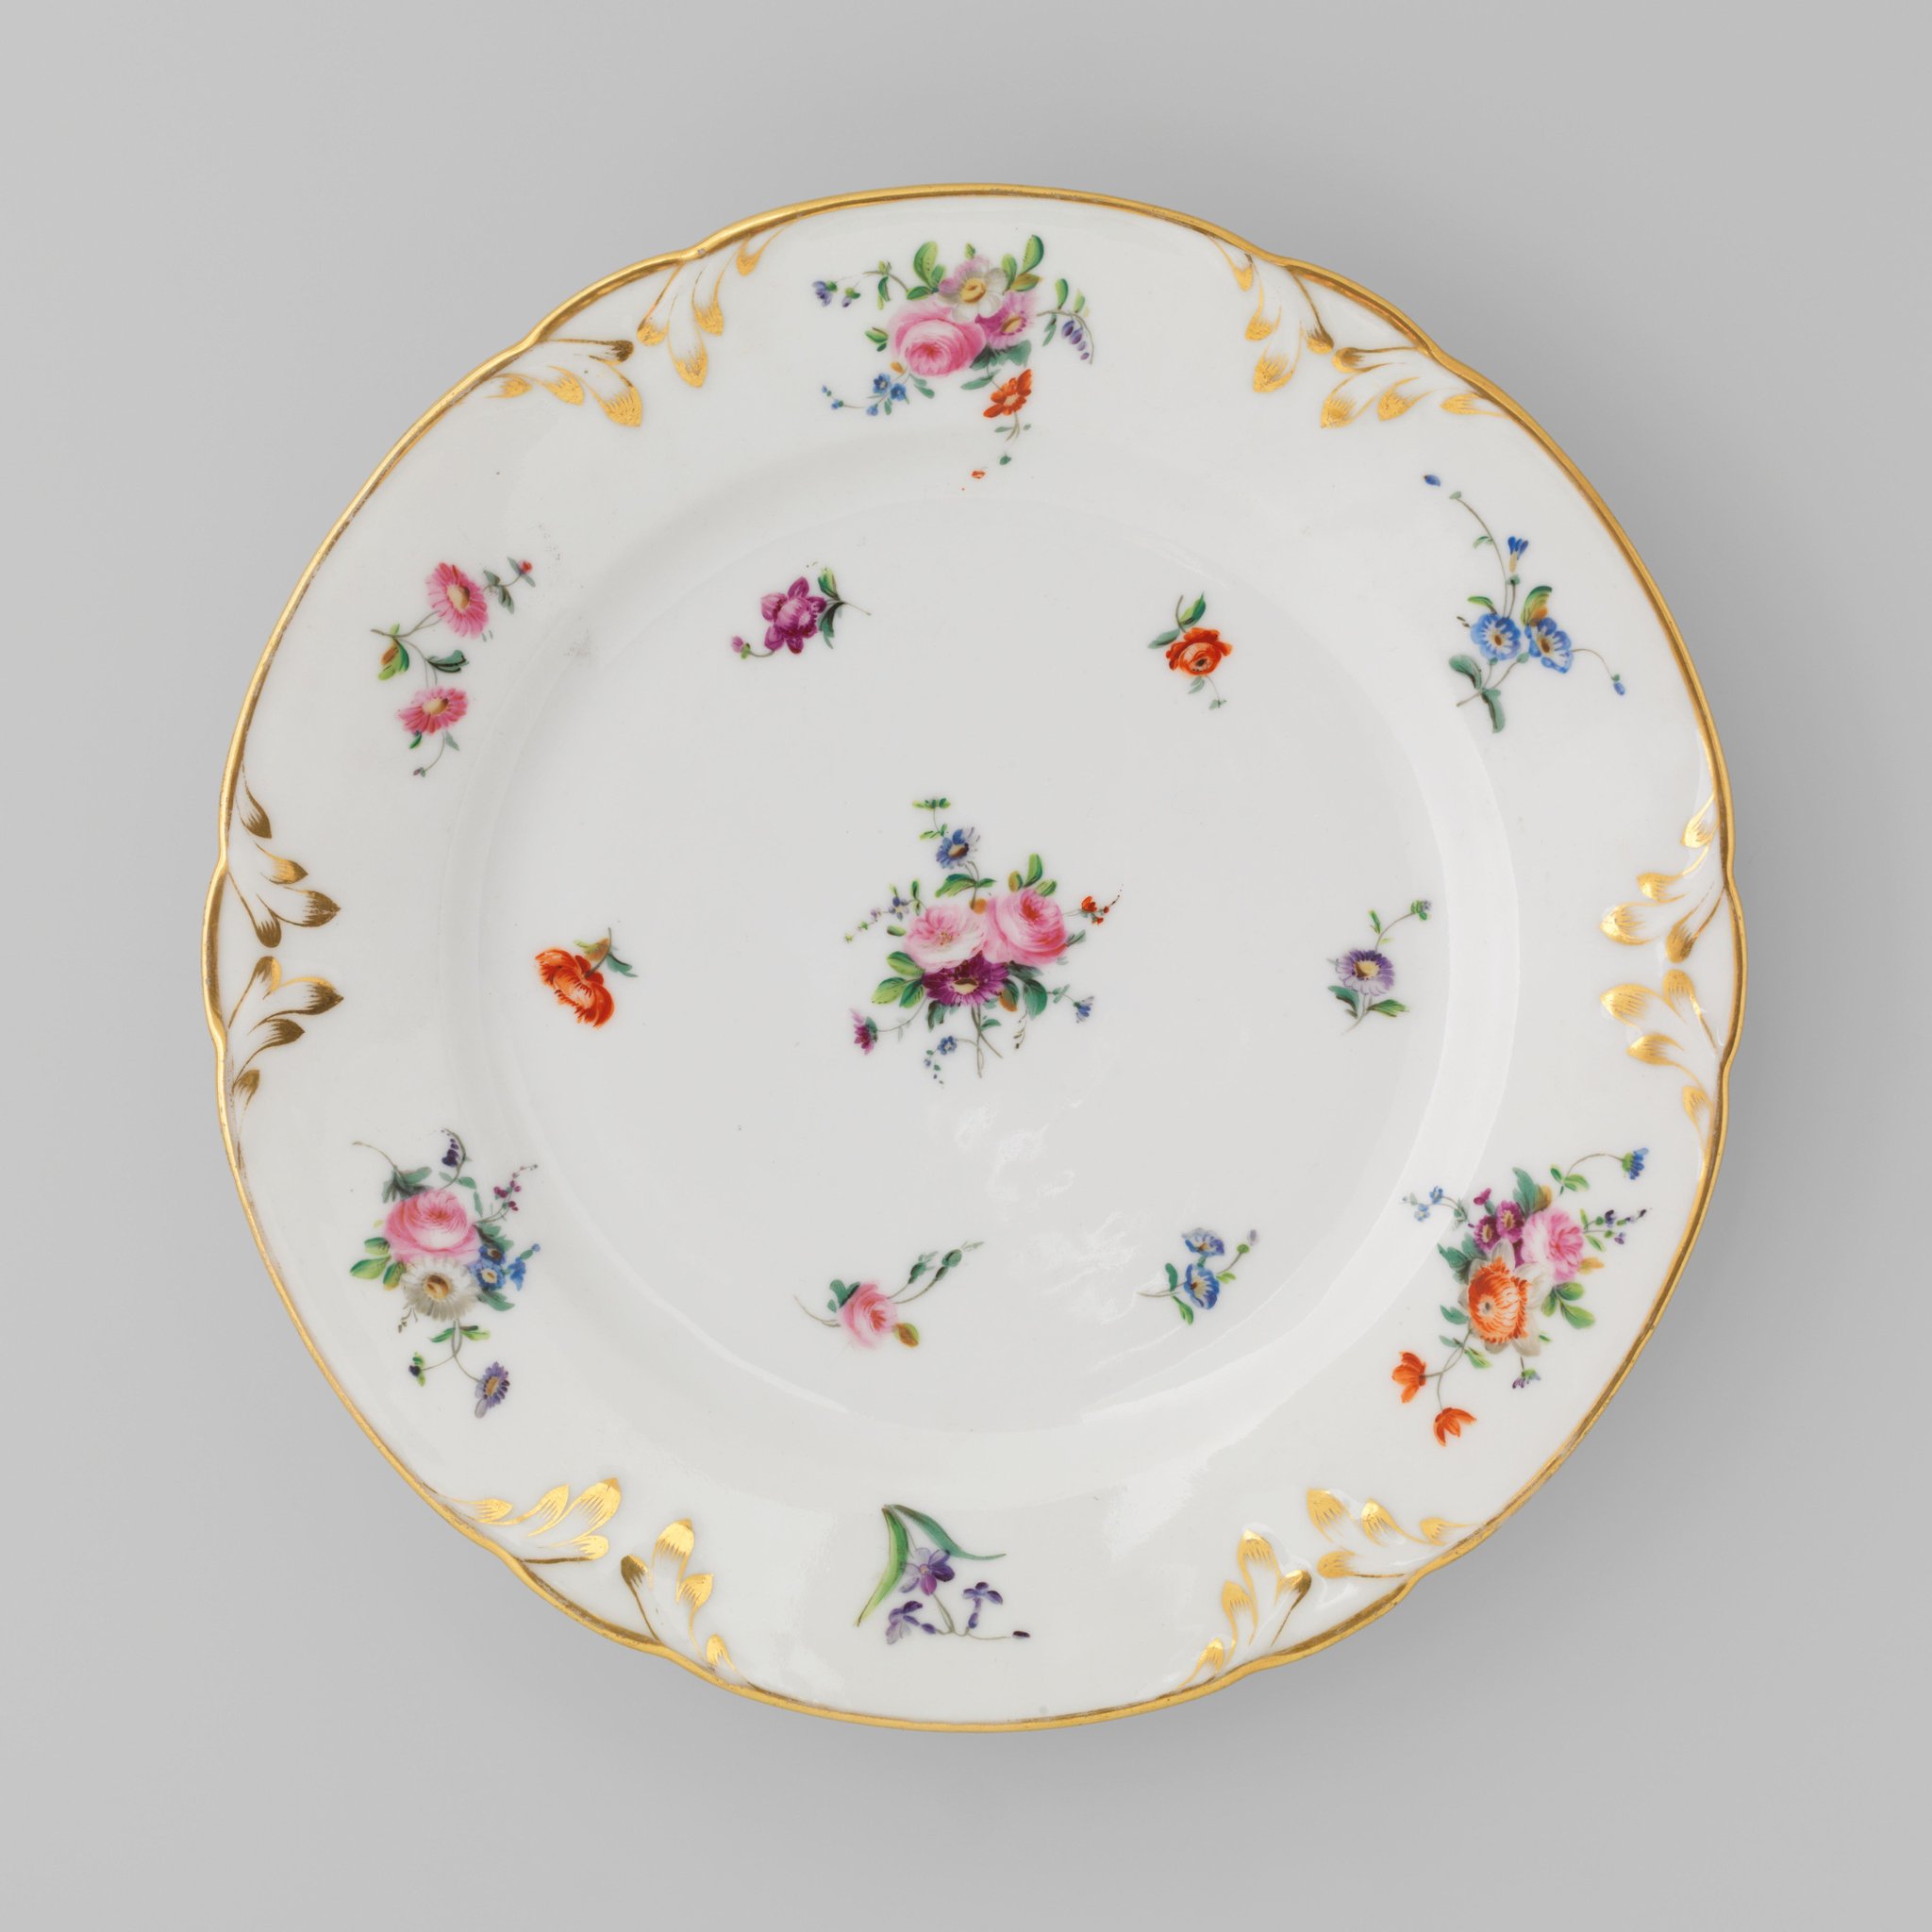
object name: plate dish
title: Plate with bouquets and flower sprays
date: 1839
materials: glaze, gold, paint, porcelain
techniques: firing, forming, gilding, turning, vitrification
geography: paris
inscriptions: mark: ‘DENUELLE/ Boulevard St. Denis 18/ à Paris’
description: Bord (dessertbord) van porselein met een gelobde rand, beschilderd op het glazuur in blauw, rood, roze, groen, geel, paars, zwart en goud. Op het plat boeketten van verschillende bloemen en strooibloemen. Vanuit de gelobde, gouden rand, gemodelleerde bladranken in reliëf, aangezet met goud. Hiertussen boeketten. Drie proenen op de onderzijde. Gemerkt op de onderzijde met 'DENUELLE/ Boulevard St. Denis 18/ à Paris'.